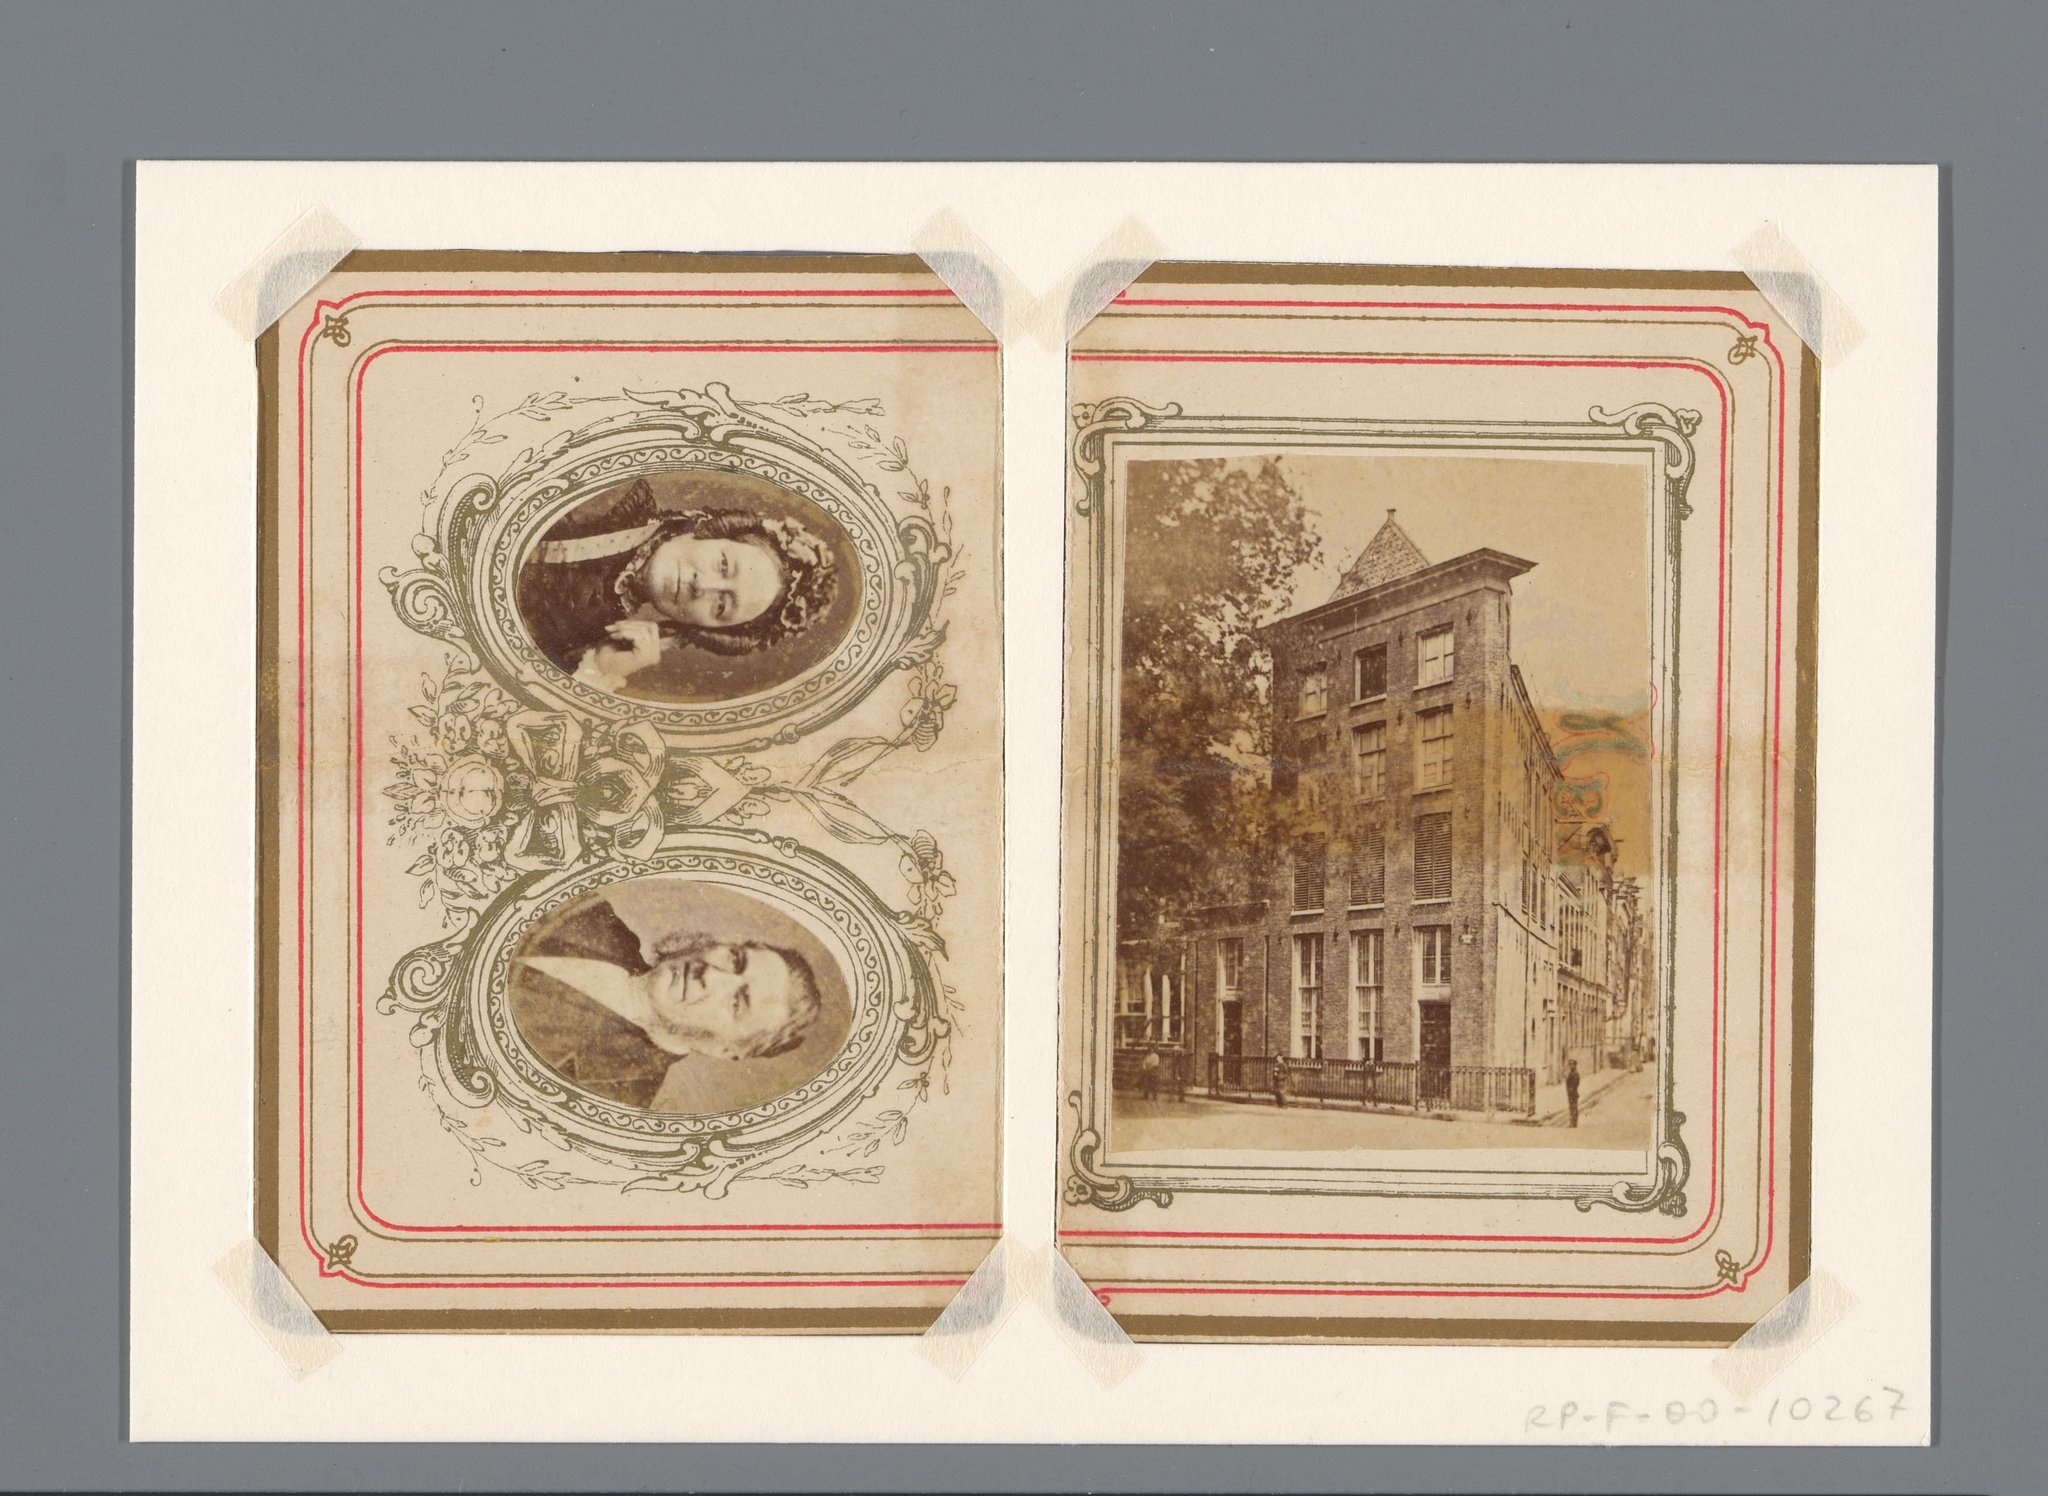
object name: photomechanical print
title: Souvenir van een vijftigjarige bruiloft met een vogel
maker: Anonymous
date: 1878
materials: cardboard, paper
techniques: autotype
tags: wedding anniversary celebration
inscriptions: inscription: ‘Souvenir/ 50 jarige echtvereeniging van den heer Lucas Jonker/ en merouw Maria Engelina Jonker van Zijp/ Bennebroek 27 juli 1878.’, annotation: ‘gouden bruiloft/ L. Jonker/ M. E. Jonker v. Zijp’